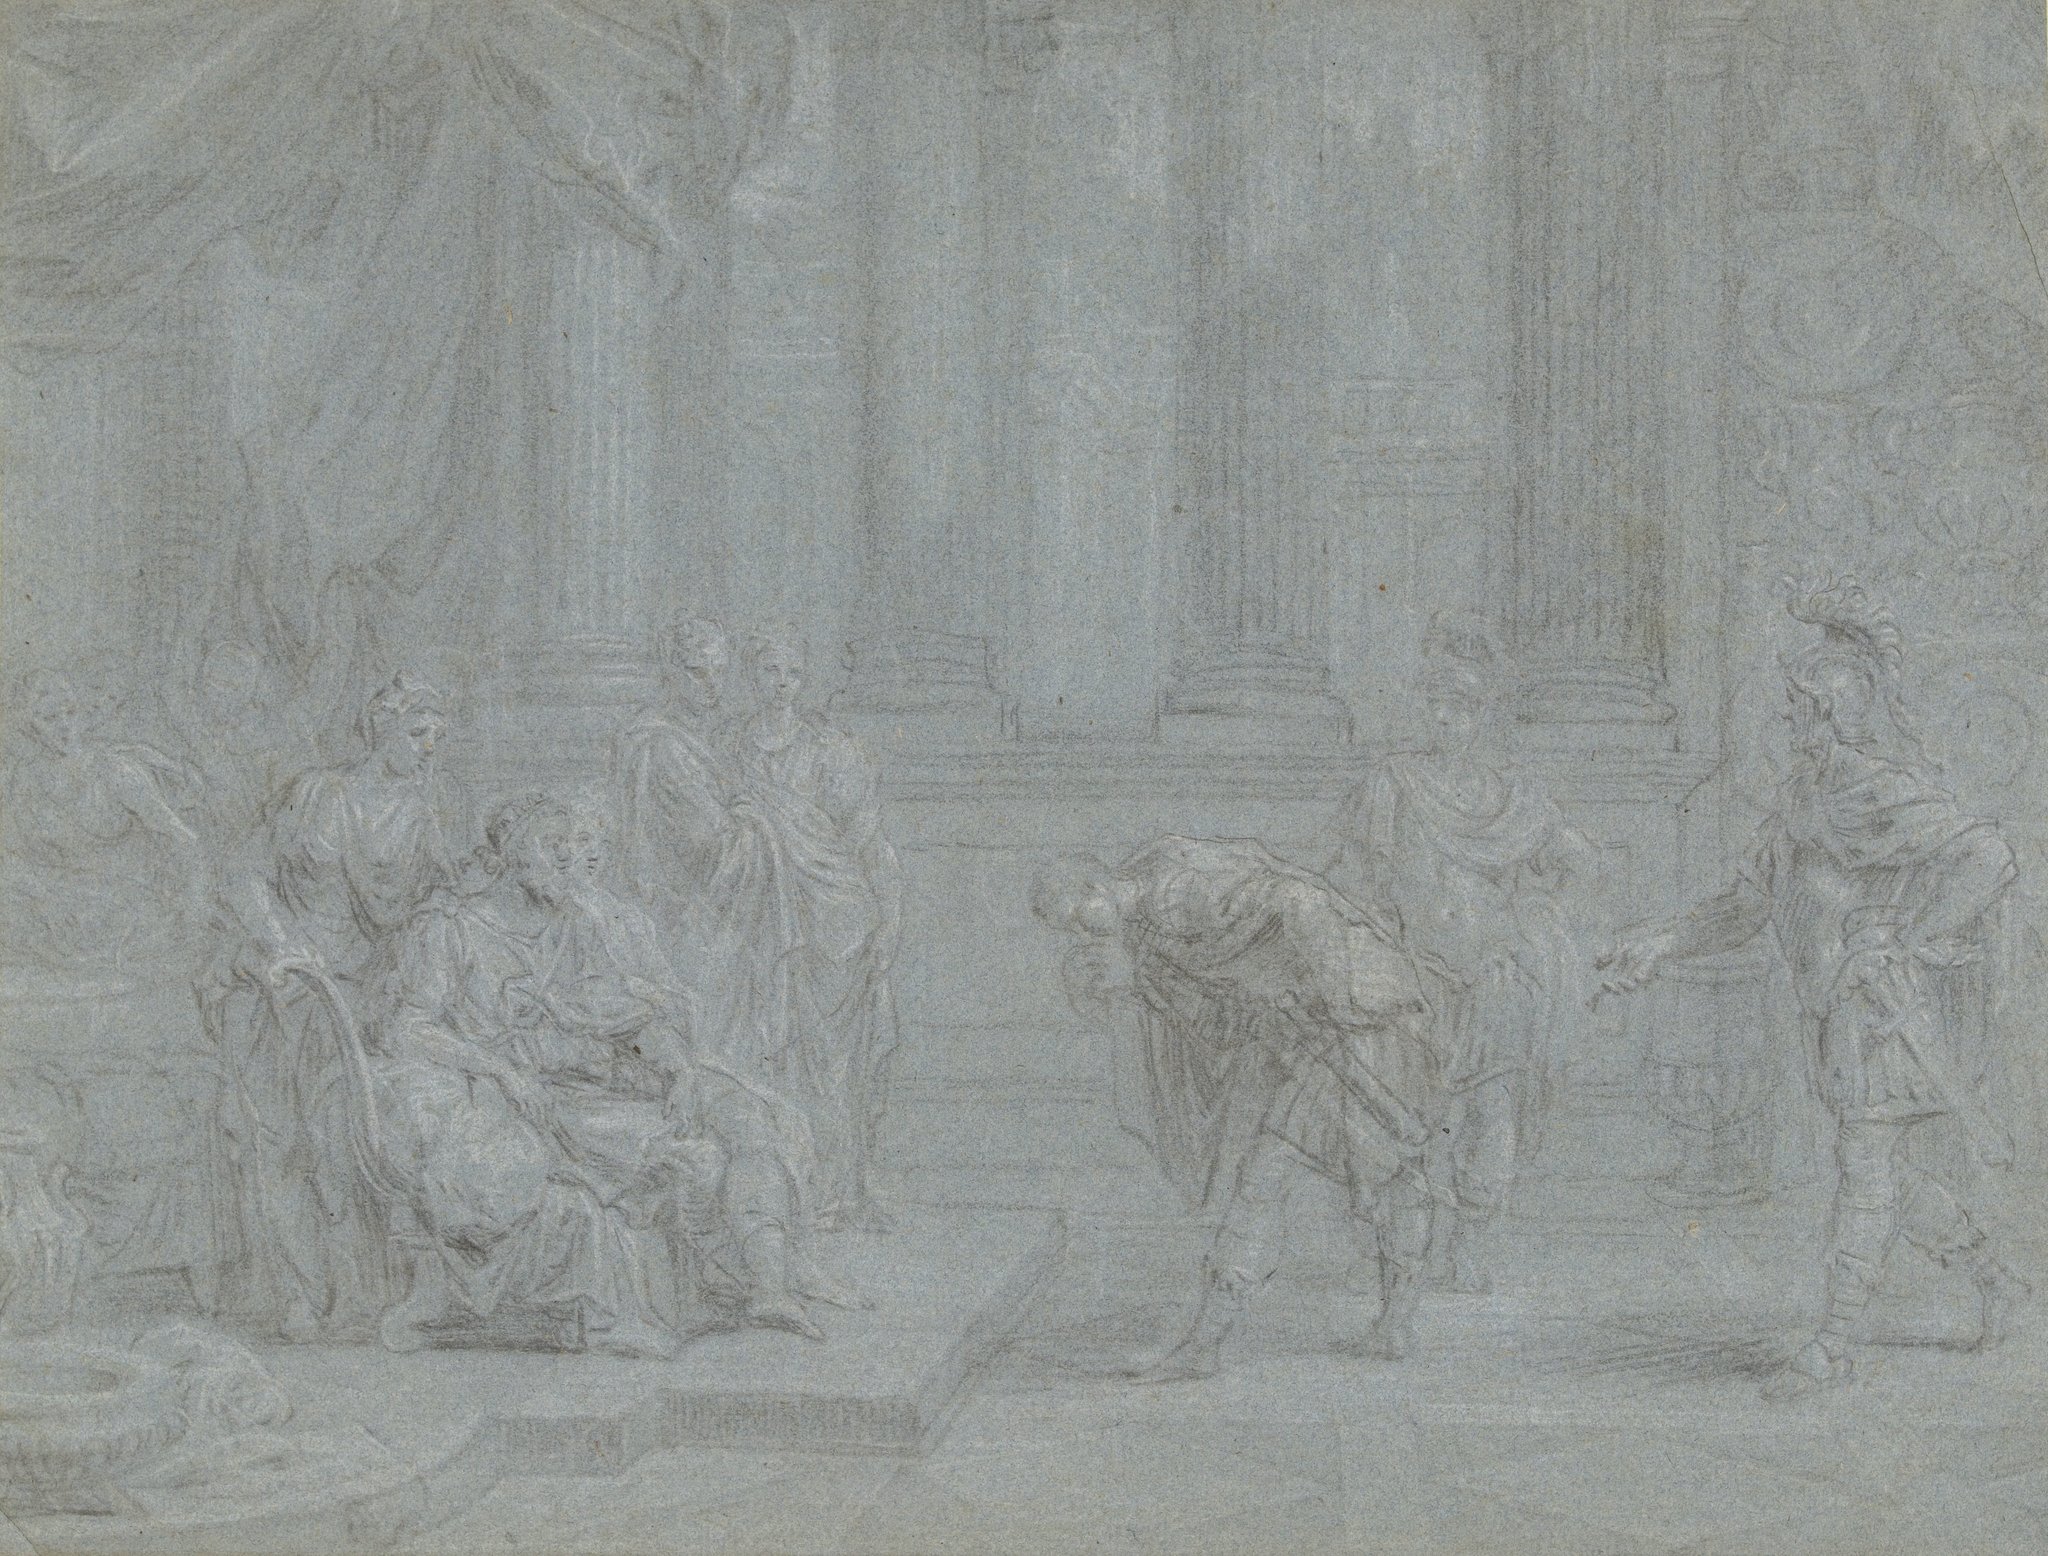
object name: drawing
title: Romeinse scène met een keizer en een veldheer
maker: mattheus ignatius van bree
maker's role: draughtsman, print maker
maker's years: 1773-1839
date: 1783-1839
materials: chalk, paper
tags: throne-room, emperor, officer, making a bow to a ruler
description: Een keizer ontvangt een veldheer in zijn paleiszaal.